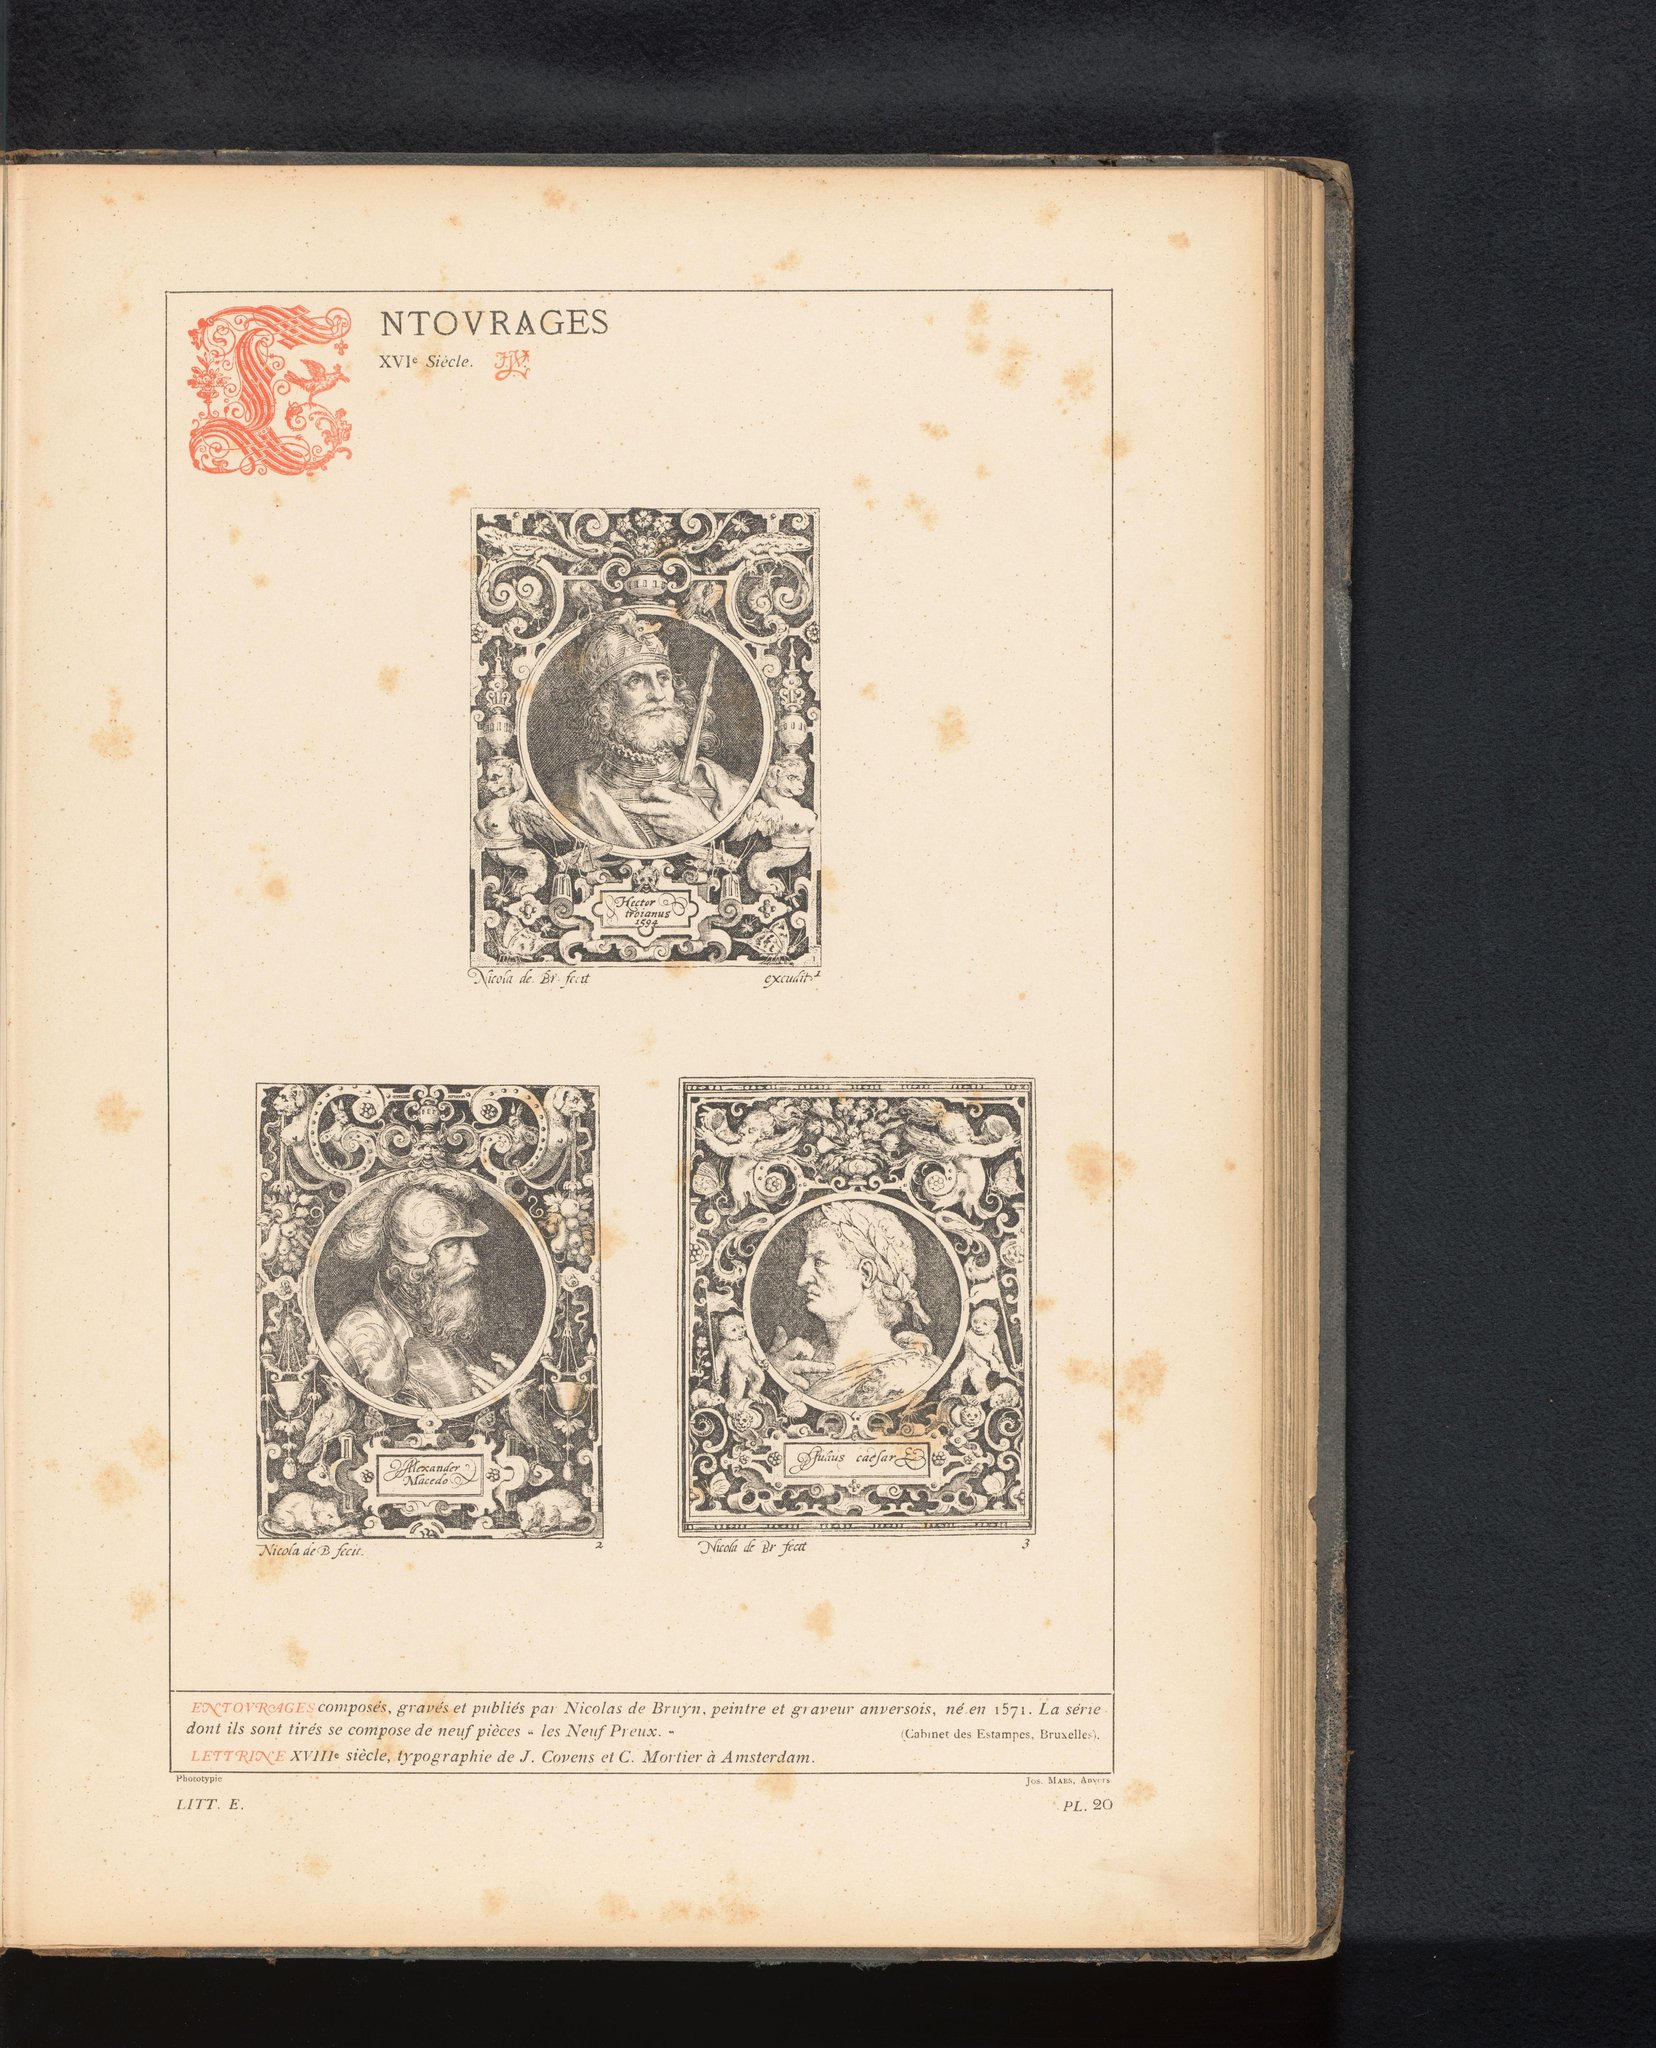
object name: reproduction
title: Reproductie van drie prenten van een portret omringd door grotesken door Nicolaes de Bruyn, afgebeeld Hektor van Troje, Alexander de Grote en Julius Caesar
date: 1875-1880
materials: paper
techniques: photolithography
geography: antwerp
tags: ornament ~ grotesque, historical persons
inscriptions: inscription: ‘ENTOURAGES composés, gravés (...)’, monogram: ‘JJvY’, inscription: ‘LITT. E. - PL. 20’